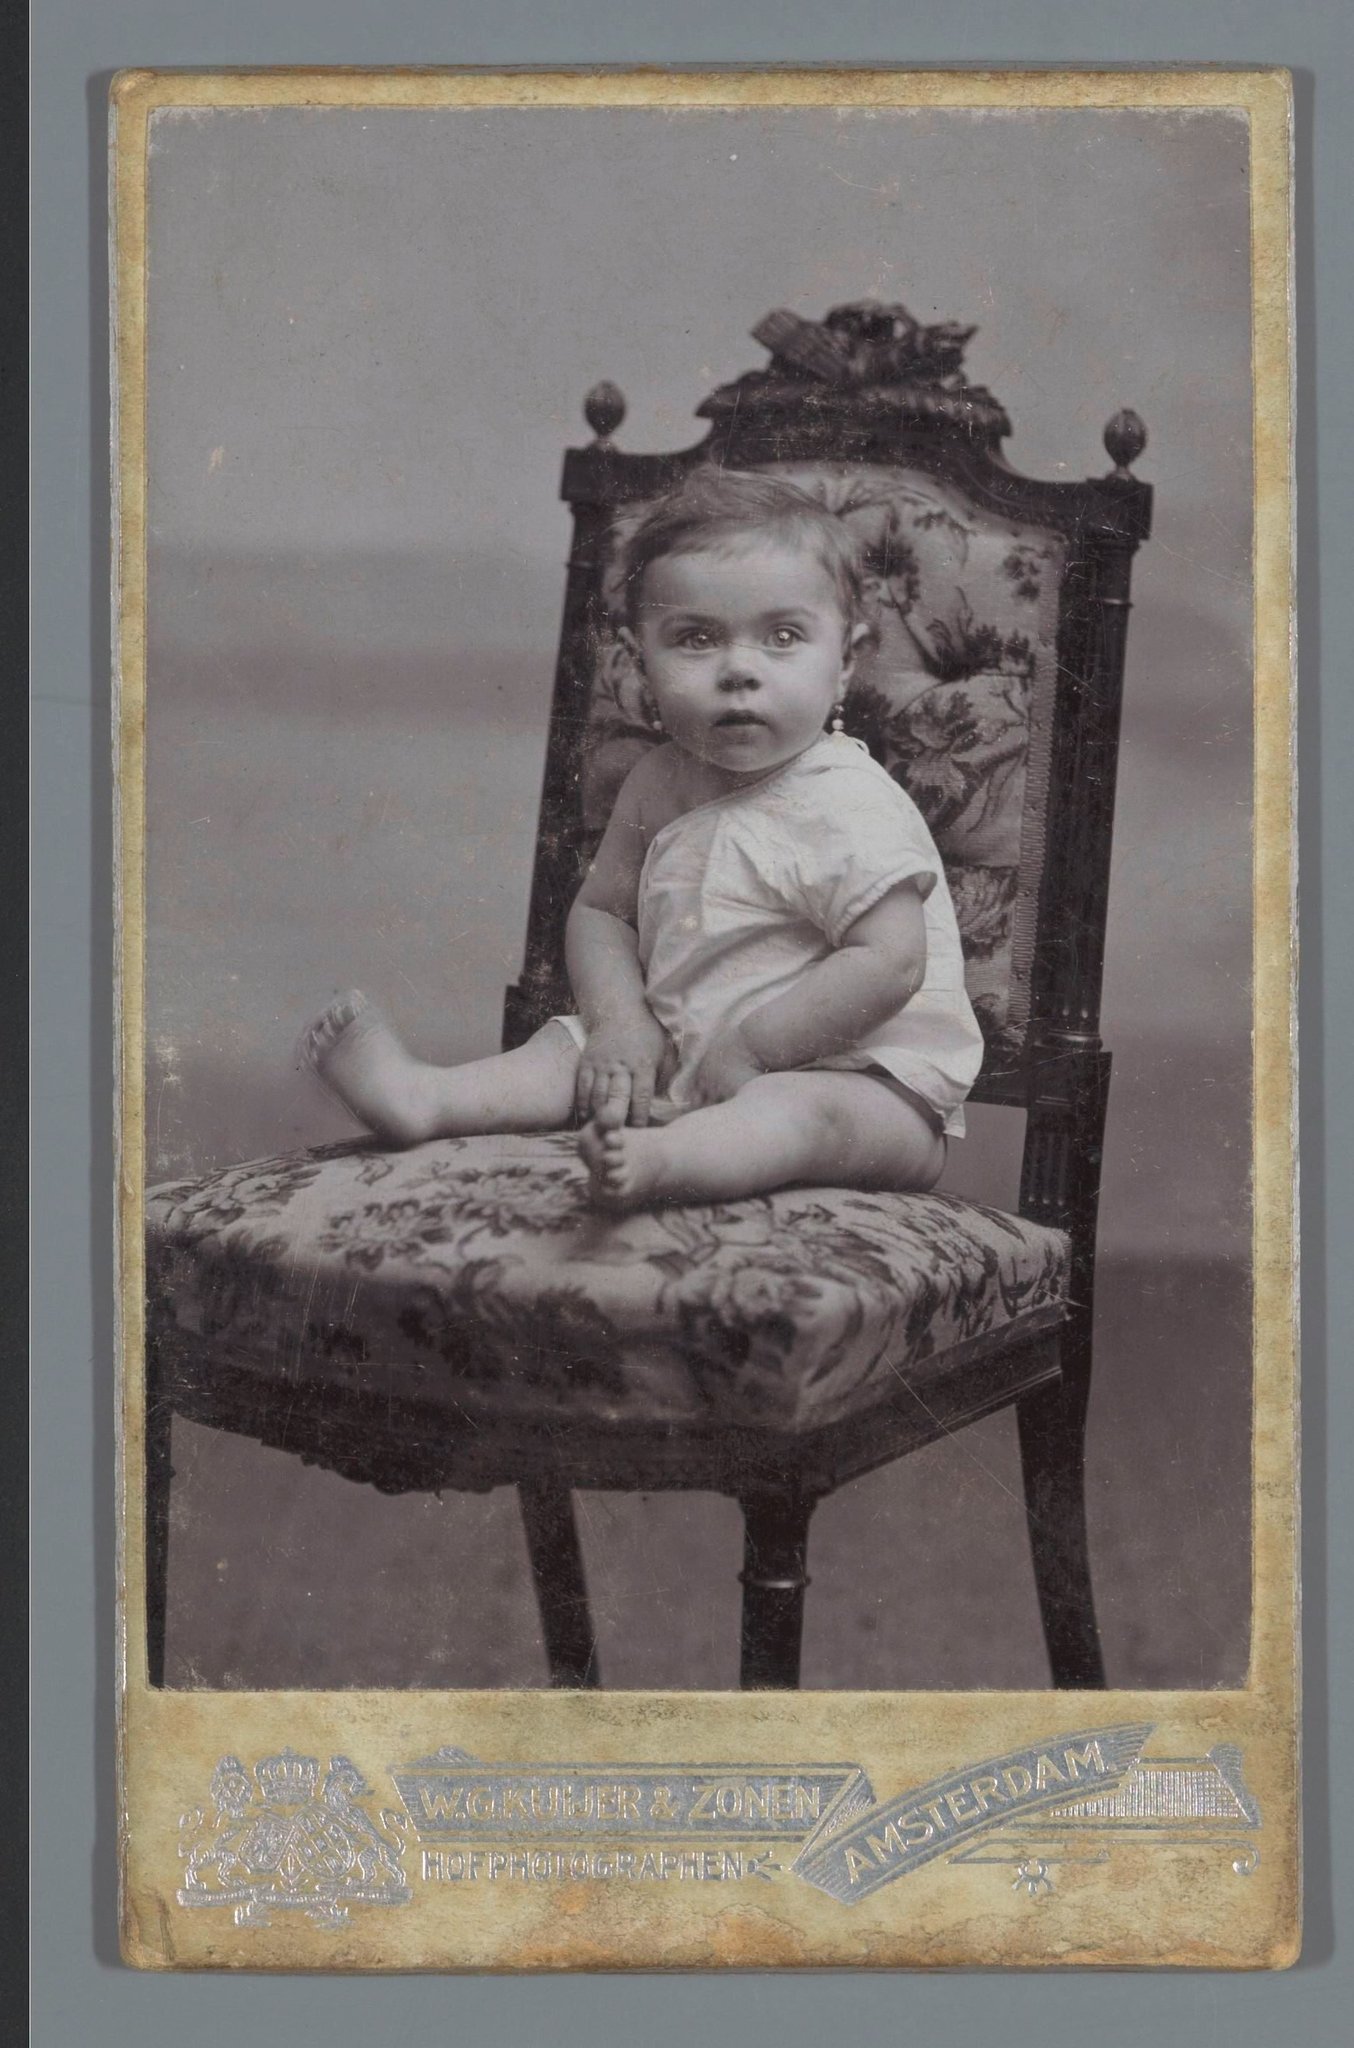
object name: carte de visite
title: Portret van een onbekende baby op een stoel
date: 1885-1906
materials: cardboard, photographic support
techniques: daylight paper print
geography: amsterdam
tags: historical persons, infant, baby, chair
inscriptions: inscription: ‘OPGERICHT 1864/ W. G. Kuijer & Zonen/ Hofphotographen/ WESTERMARKT 19./ AMSTERDAM/ Spéciale Inrichting voor Vergrootingen in alle Formaten.’